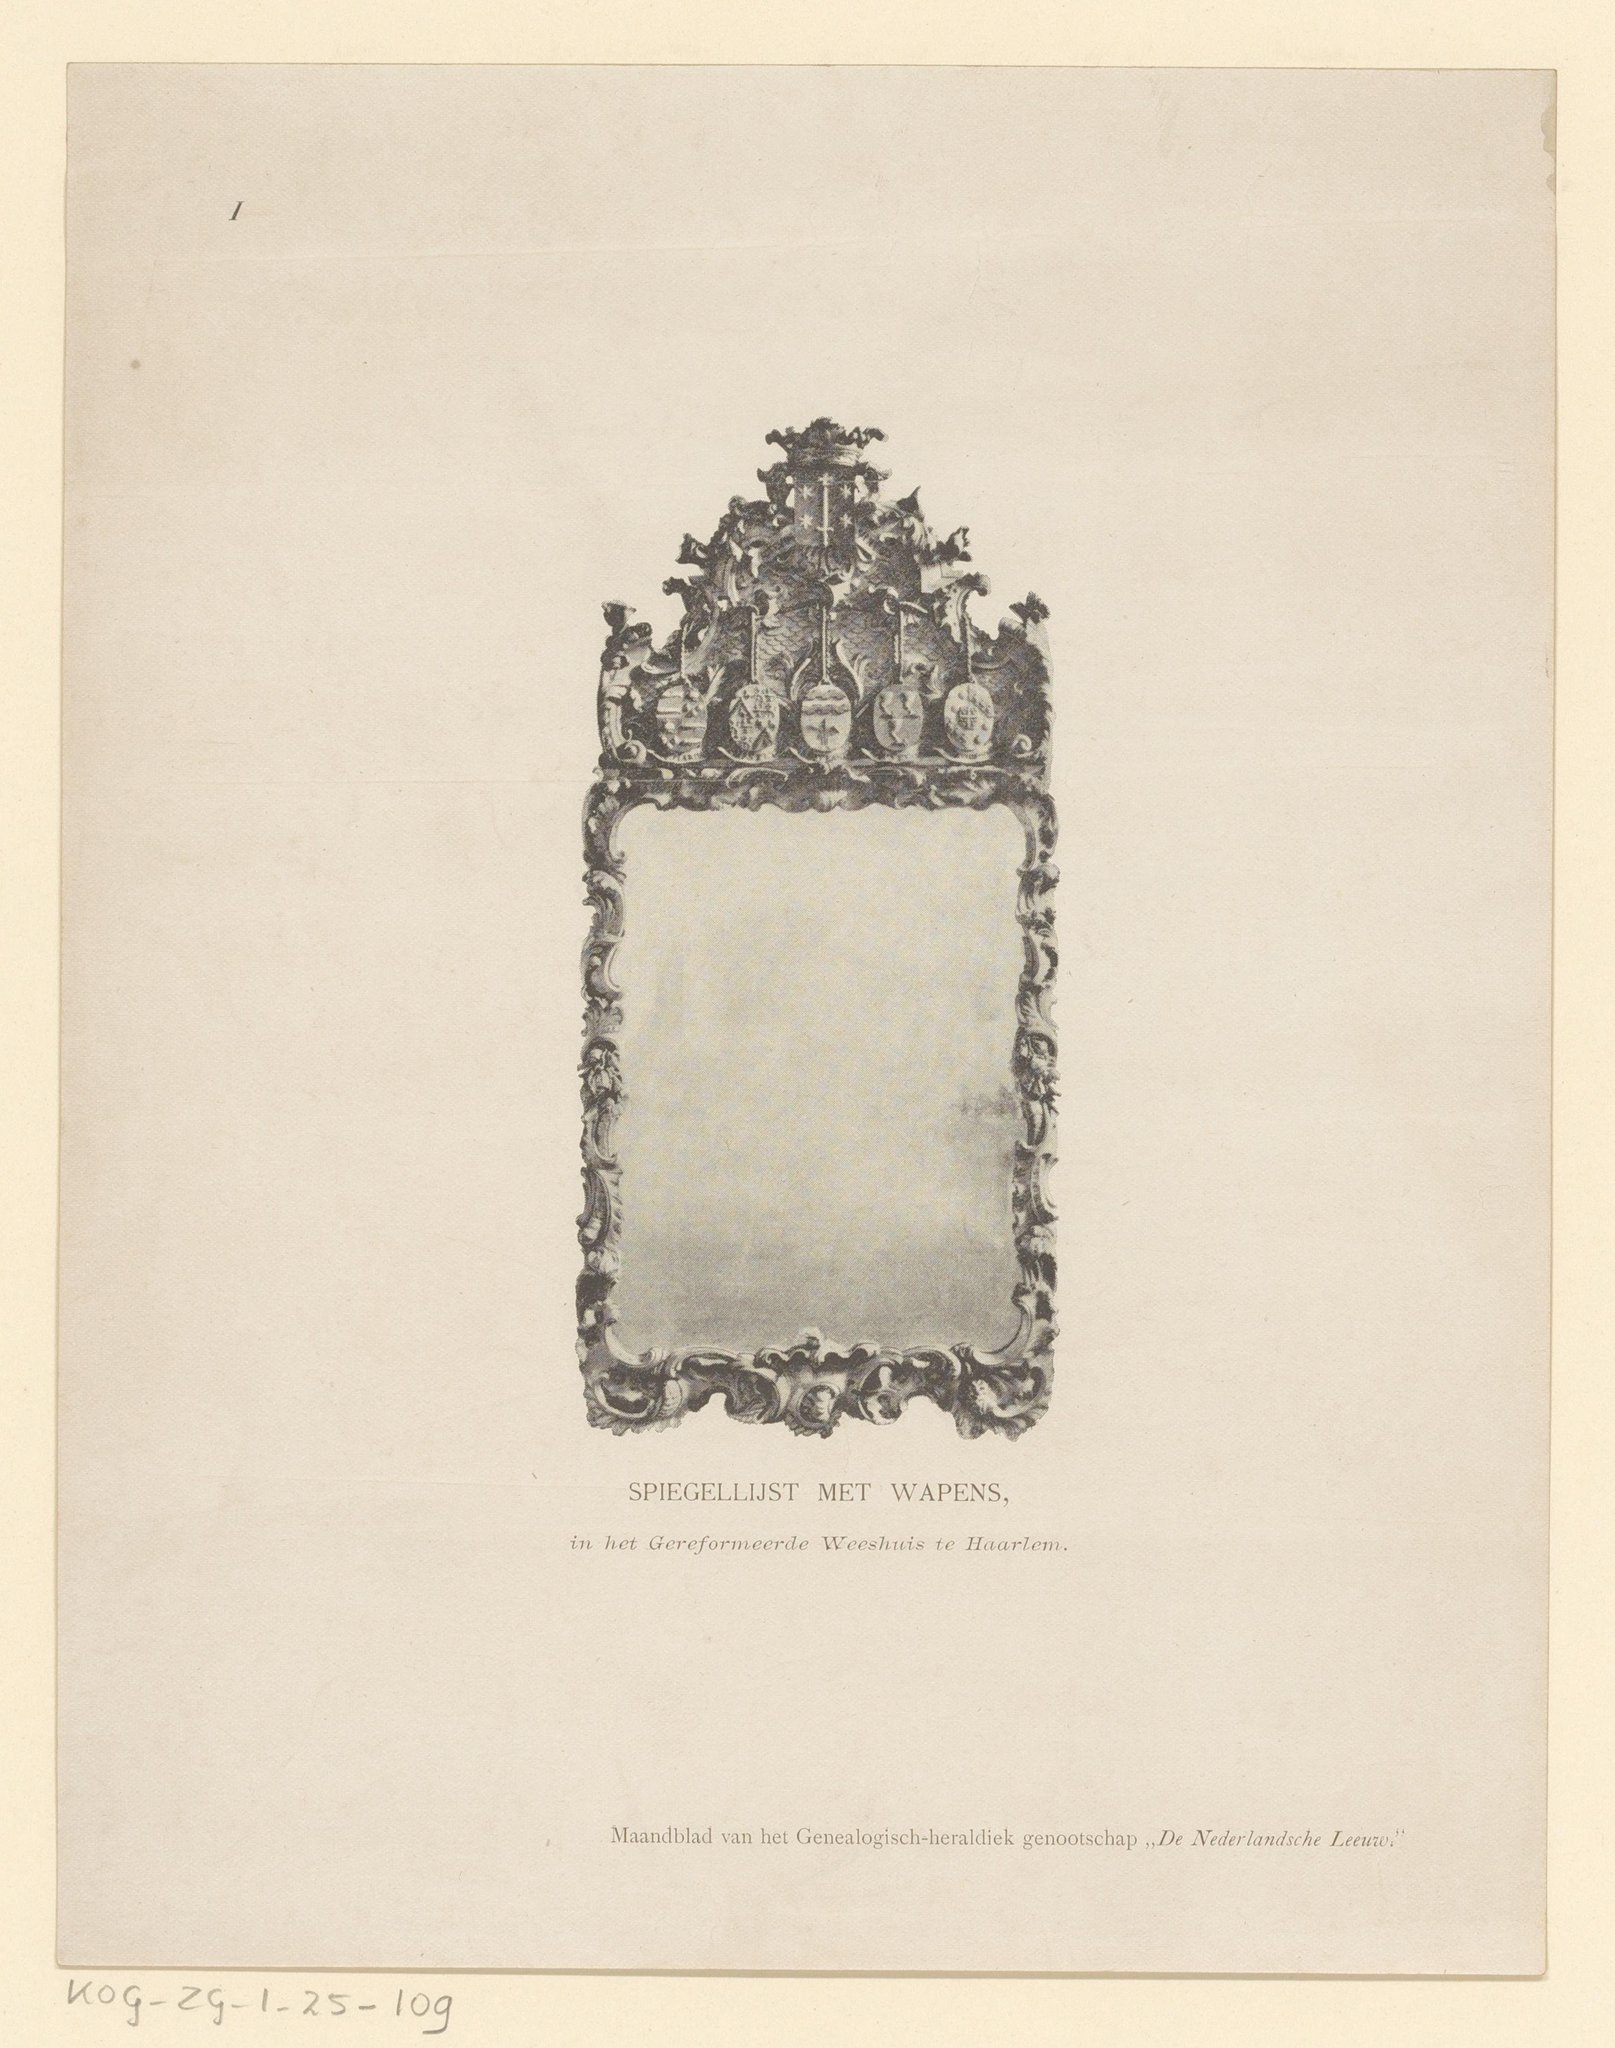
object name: photomechanical print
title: Spiegel met wapenschilden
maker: Anonymous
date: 1895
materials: paper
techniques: autotype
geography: the hague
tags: mirror, armorial bearing, heraldry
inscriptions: stamp, stamp, collector's mark: Lugt 1641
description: Linksboven genummerd: I. Onderwerpsrubrieken binnen de Atlas Zeden en Gewoonten: Zeden en Gewoonten in Engeren Zin, De Woning, Binnenhuizen, Meubelen.